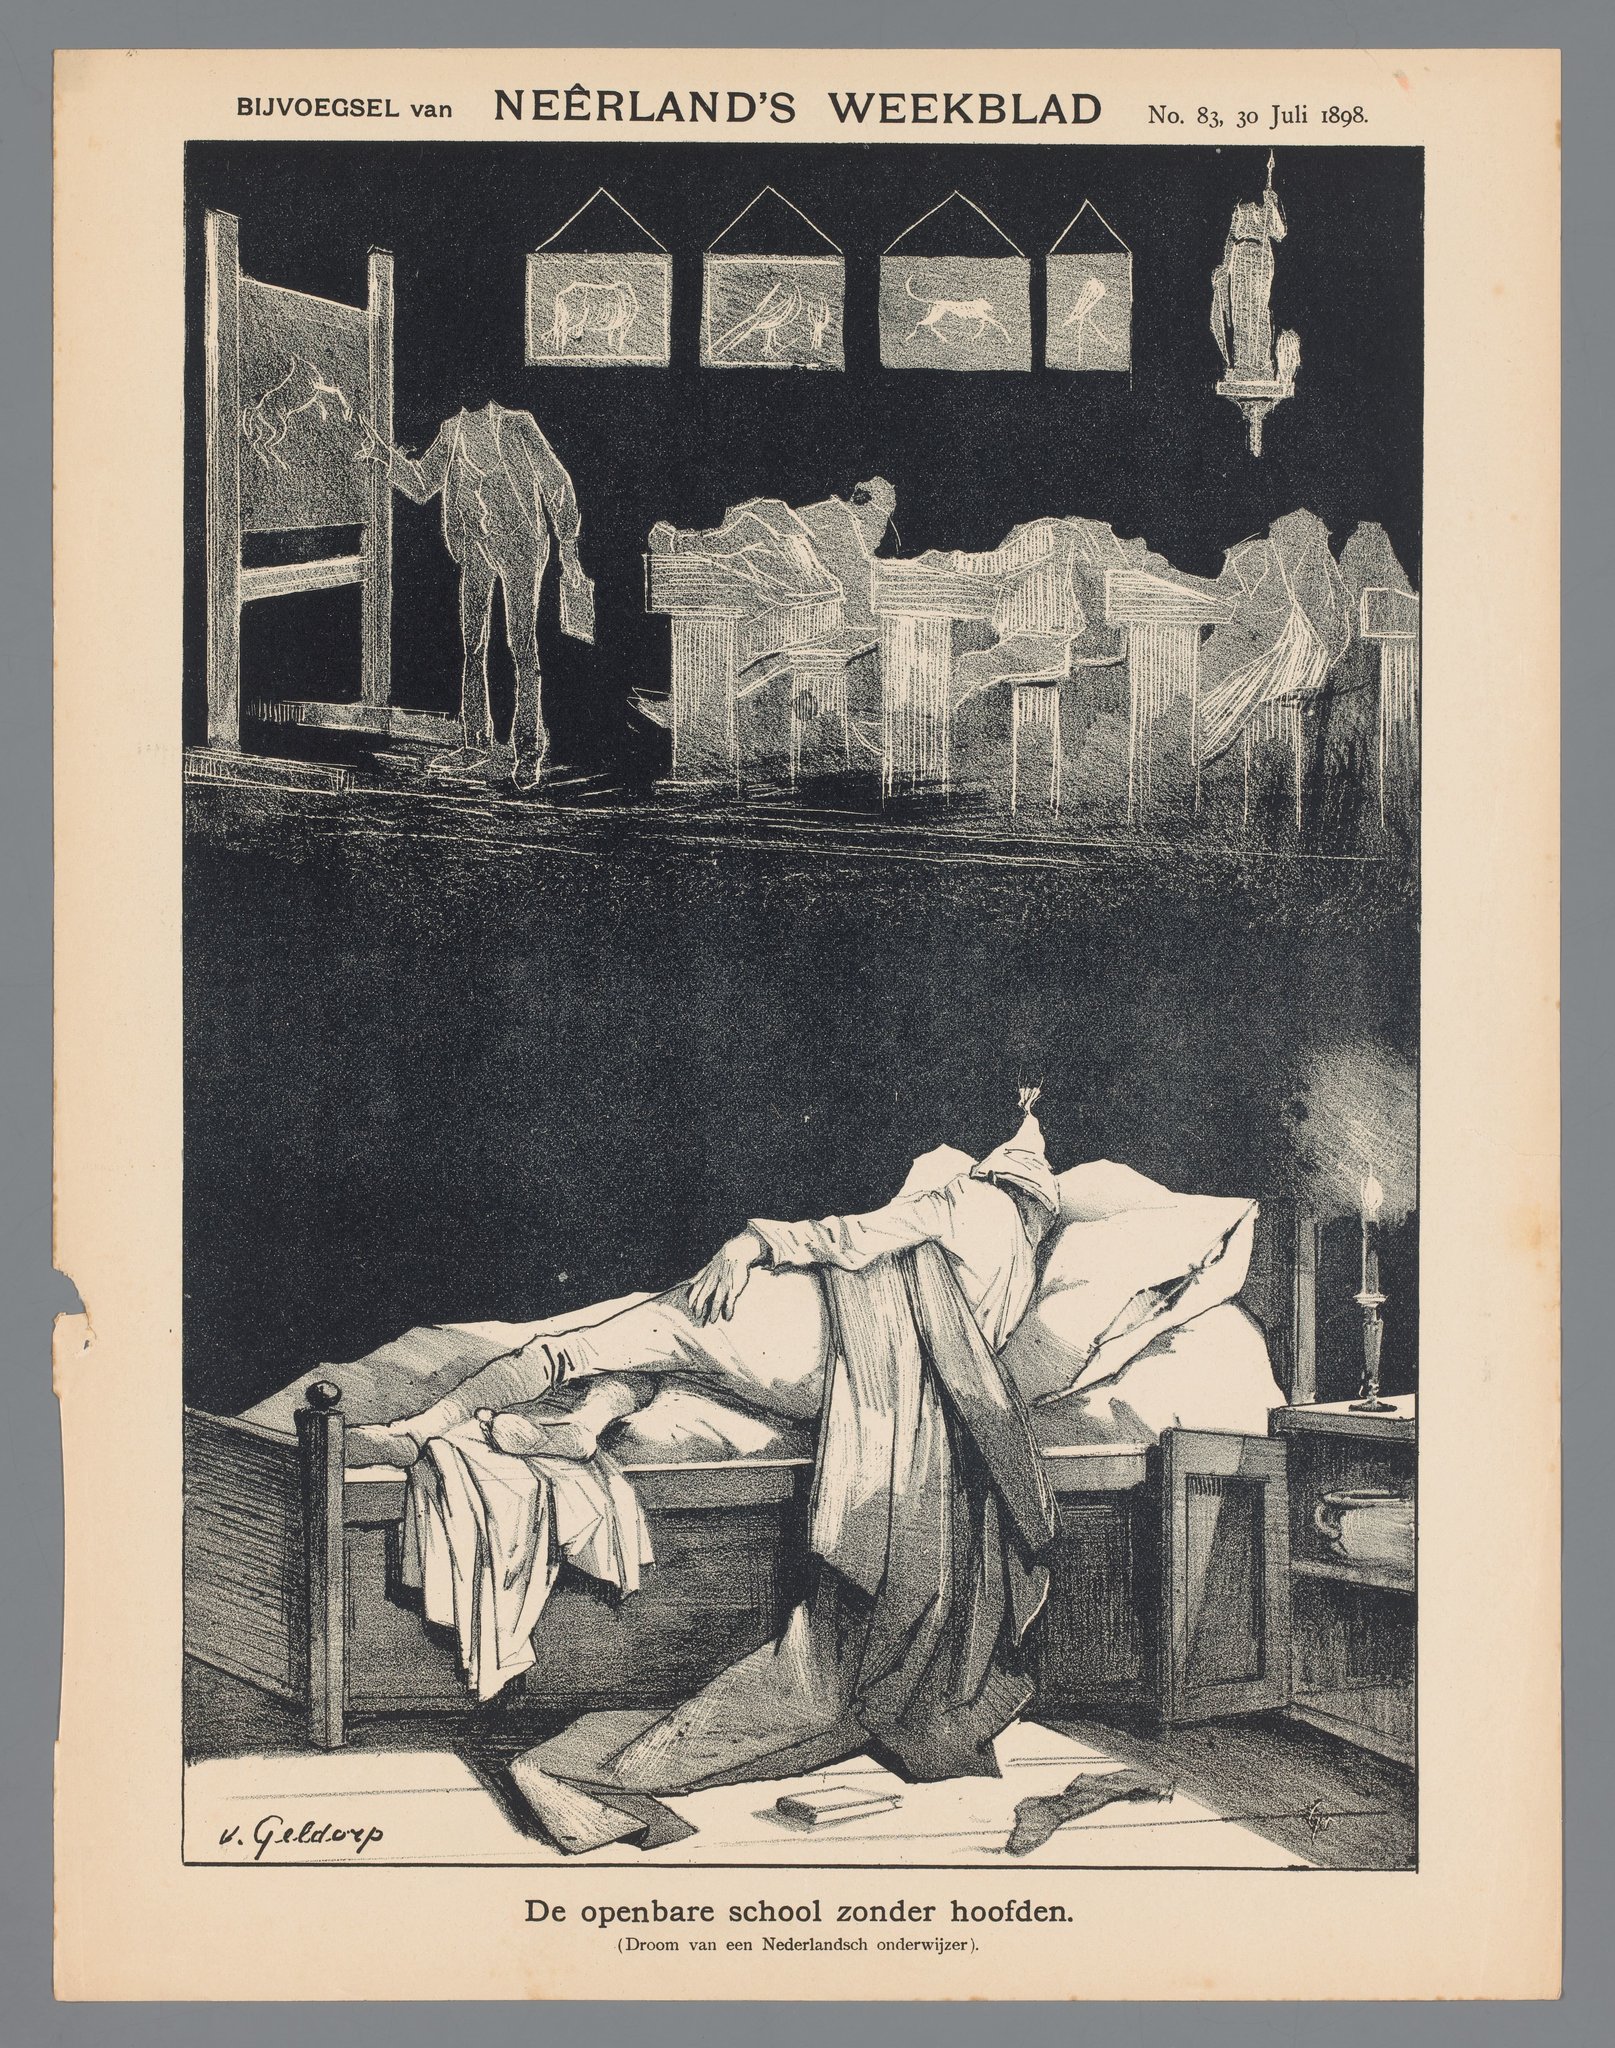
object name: cartoon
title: De openbare school zonder hoofden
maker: petrus van geldorp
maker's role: draughtsman, print maker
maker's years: 1872-1939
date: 1898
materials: paper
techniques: lithograph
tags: dream, scholastic education, tuition, political caricatures and satires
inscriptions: date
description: Prent uit het bijvoegsel van: Neêrland’s Weekblad, nr. 83, 30 juli 1898.